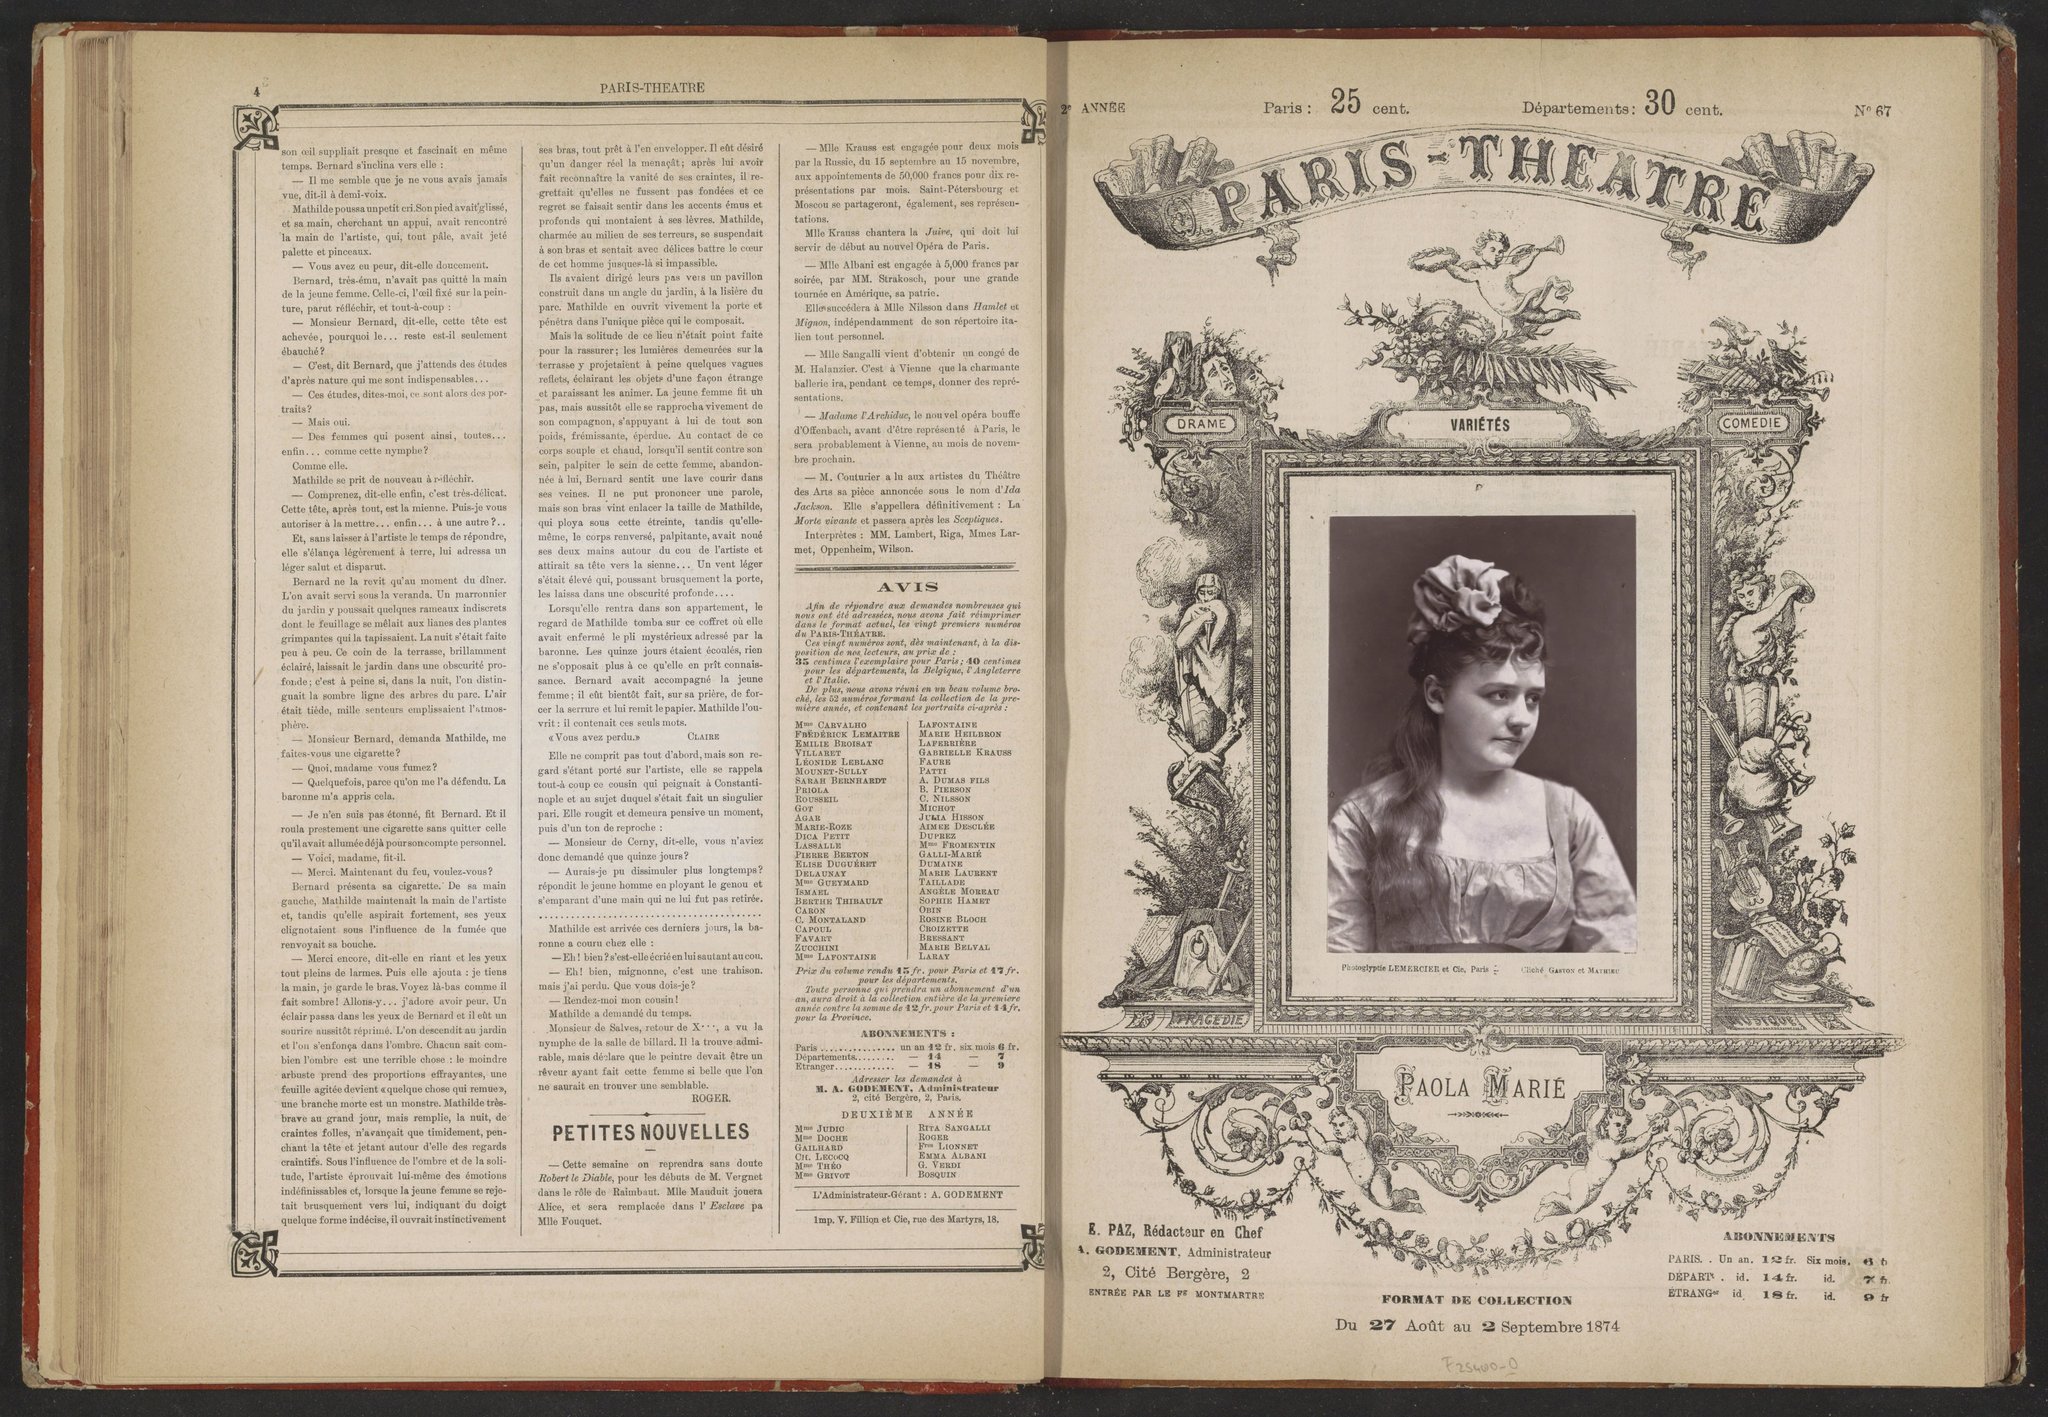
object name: photomechanical print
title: Portret van Paola Marié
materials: paper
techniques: woodburytype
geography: paris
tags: portrait of opera-singer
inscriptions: inscription: ‘Du 27 Août au 2 Septembre 1874’, number: ‘No 67’